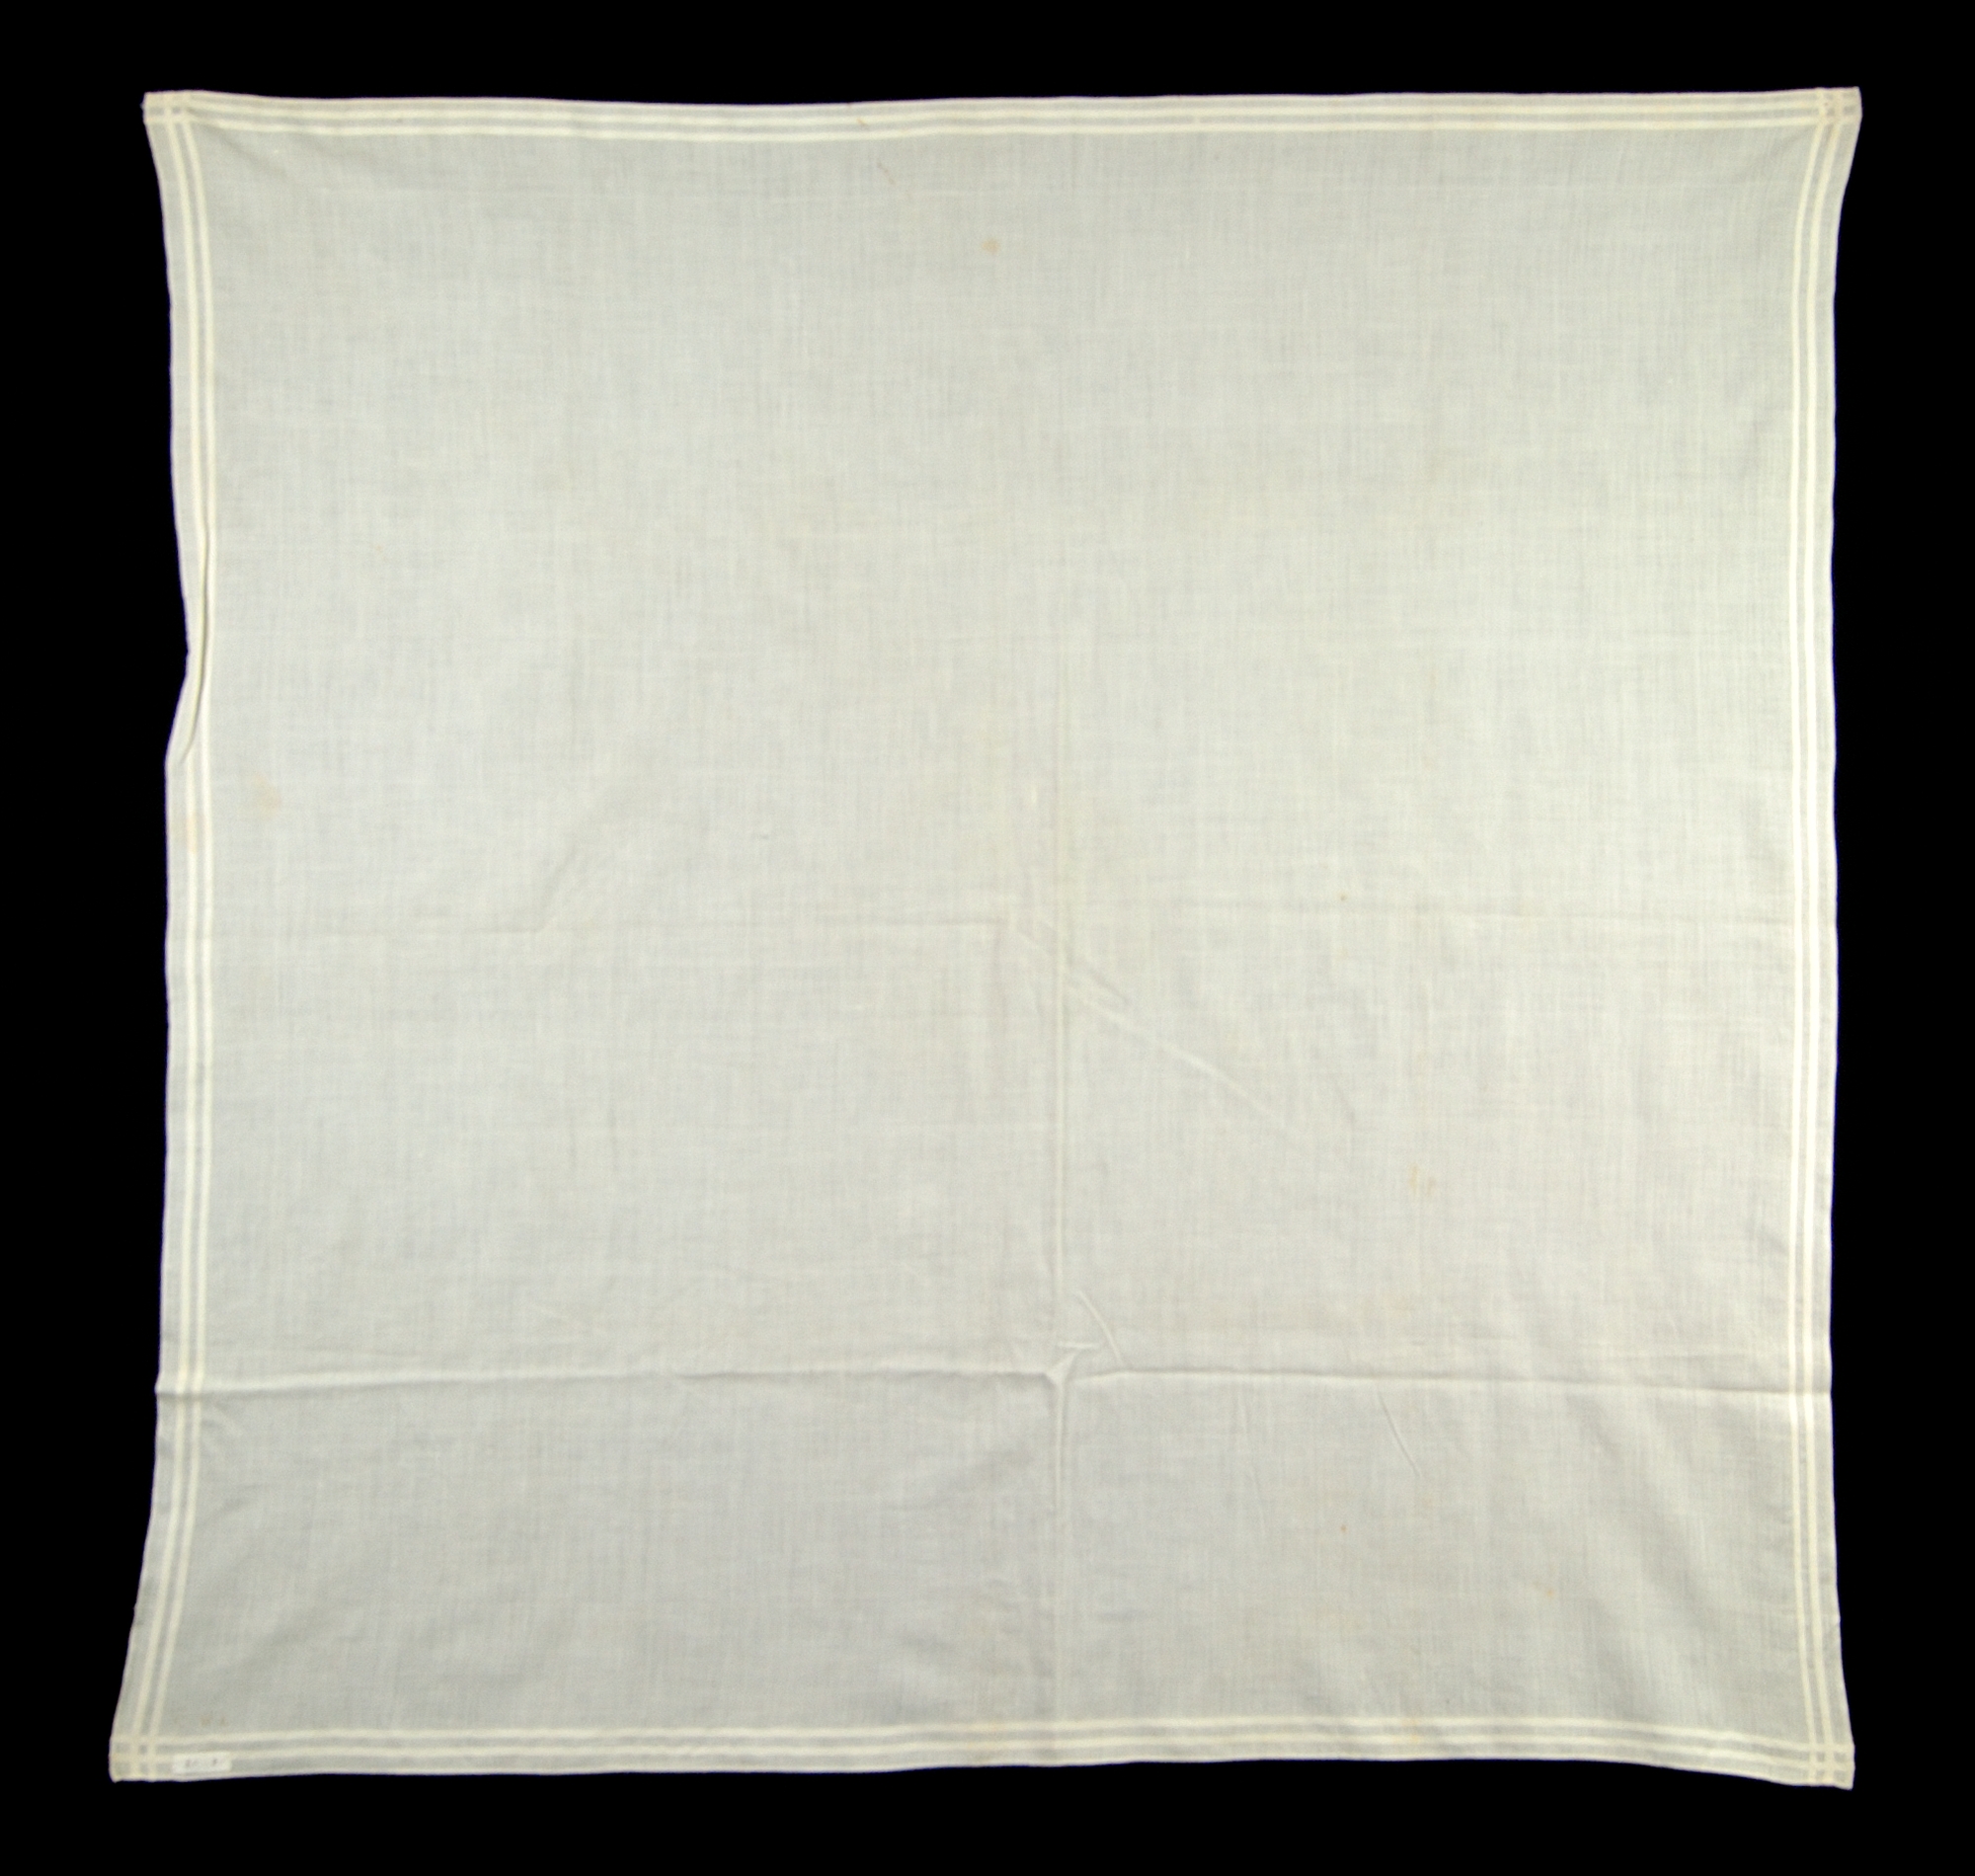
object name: kerchief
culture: american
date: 1840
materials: cotton